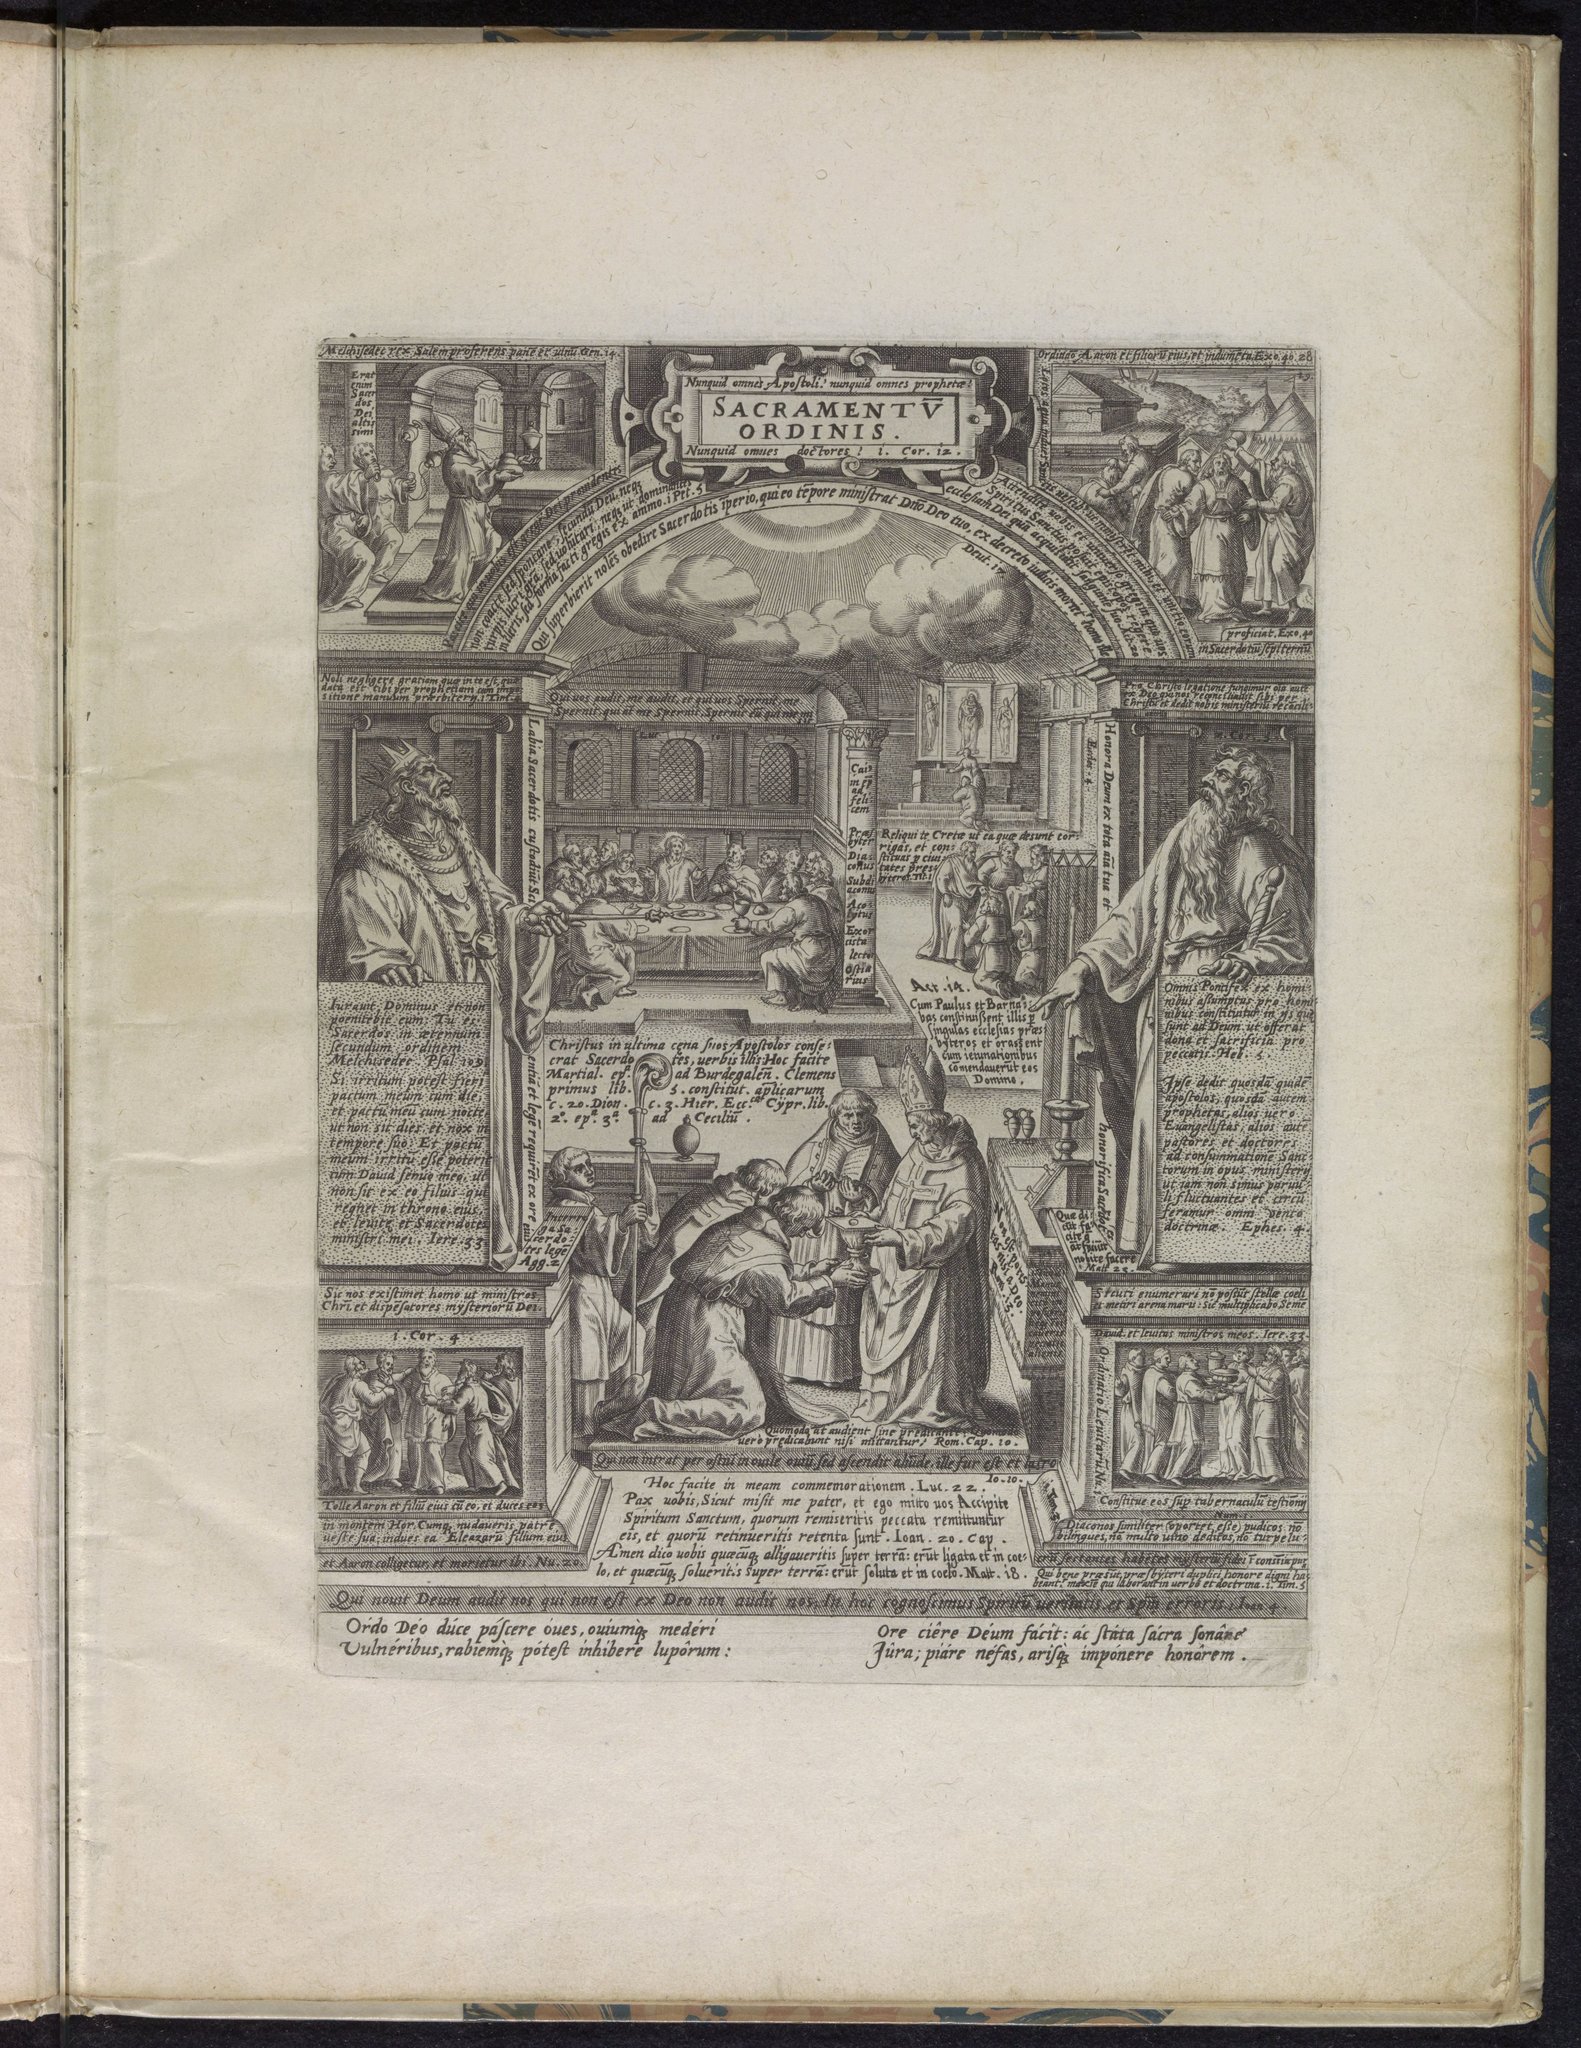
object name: album leaf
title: Sacramentum Ordinis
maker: philips galle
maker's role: print maker, publisher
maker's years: 1537-1612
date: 1576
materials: paper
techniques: engraving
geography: antwerp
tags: melchizedek, usually in front of an altar, offers bread and wine in a chalice, 'ordinatio', ordination ~ the fifth of the seven sacraments, aaron and his four sons are ordained by moses (leviticus 8)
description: Het sacrament van de priesterwijding. In het midden een voorstelling van twee mannen die tot priester worden gewijd. Op de achtergrond het laatste avondmaal links en rechts Paulus en Barnabas die oudsten aanstellen in een gemeente. Rondom voorstellingen van Bijbelverhalen die te maken hebben met gewijd leven. Linksboven de priester en koning Melchizedek, rechtsboven de wijding van Aäron tot hogepriester, rechtsonder de wijding van de Levieten en linksonder Aäron en zijn zonen. Links en rechts koning David en Paulus. In de voorstelling diverse Bijbelteksten in het Latijn. Onder de voorstelling een vierregelig vers in het Latijn. Deze prent maakt deel uit van een album.